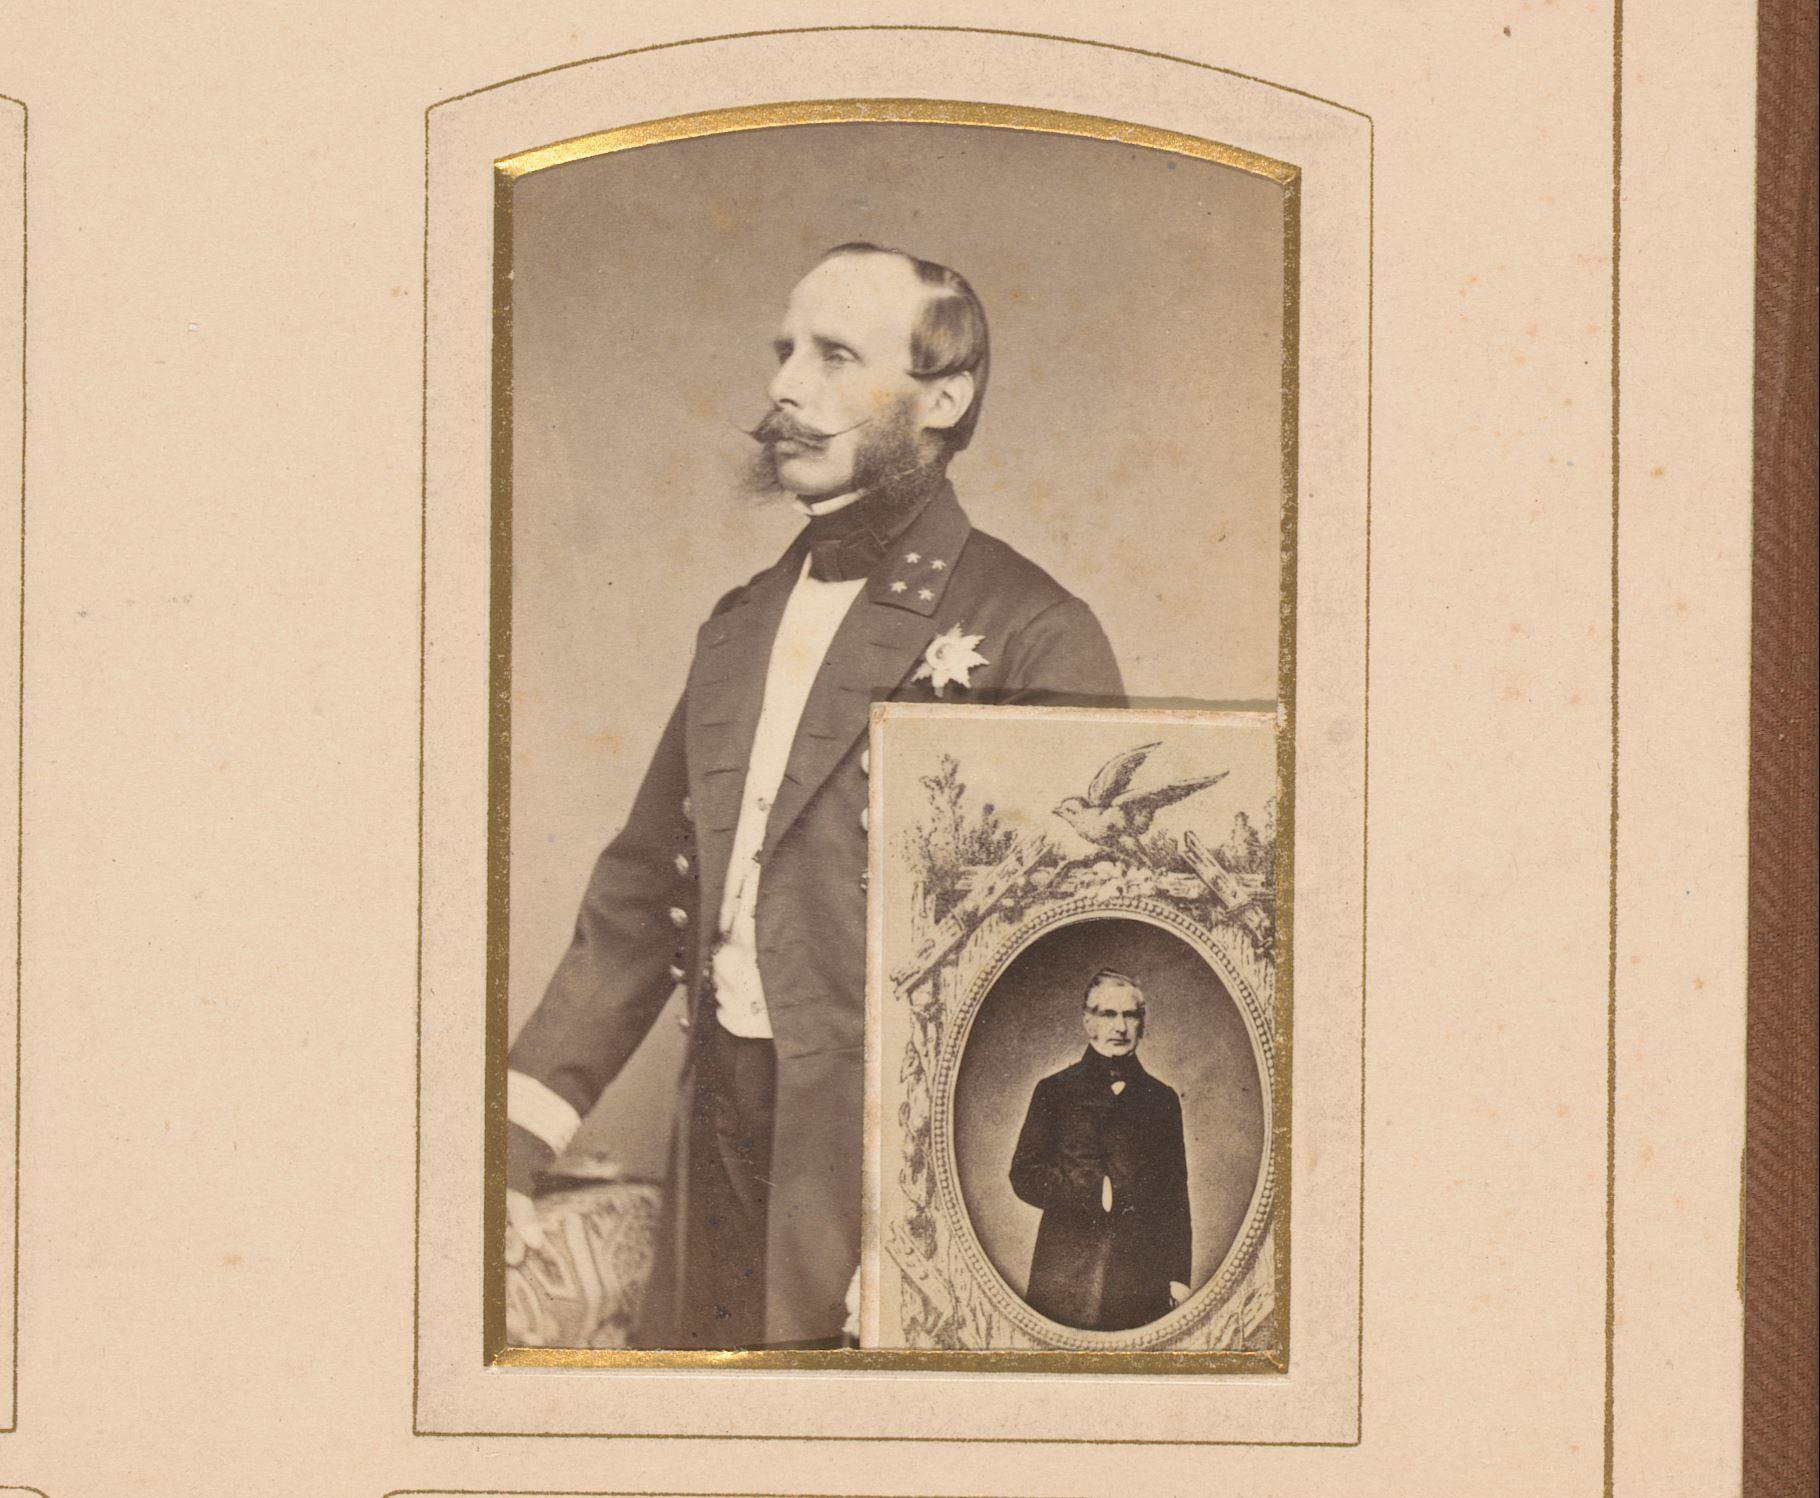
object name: album leaf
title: Portret van Prins Hendrik van Oranje-Nassau, prins der Nederlanden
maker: johann schäfer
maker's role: fotograaf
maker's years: 1822-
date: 1860-1879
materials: cardboard, photographic support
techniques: albumen print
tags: hendrik (prins der nederlanden), prince, historical persons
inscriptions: inscription: ‘J. SCHÄFER/ Photograph/ FRANKFURT A. M./ Hochstrasse 40.’, name: ‘Prins Heinrich d. Niederlande’, name: ‘Prins Hendrik’